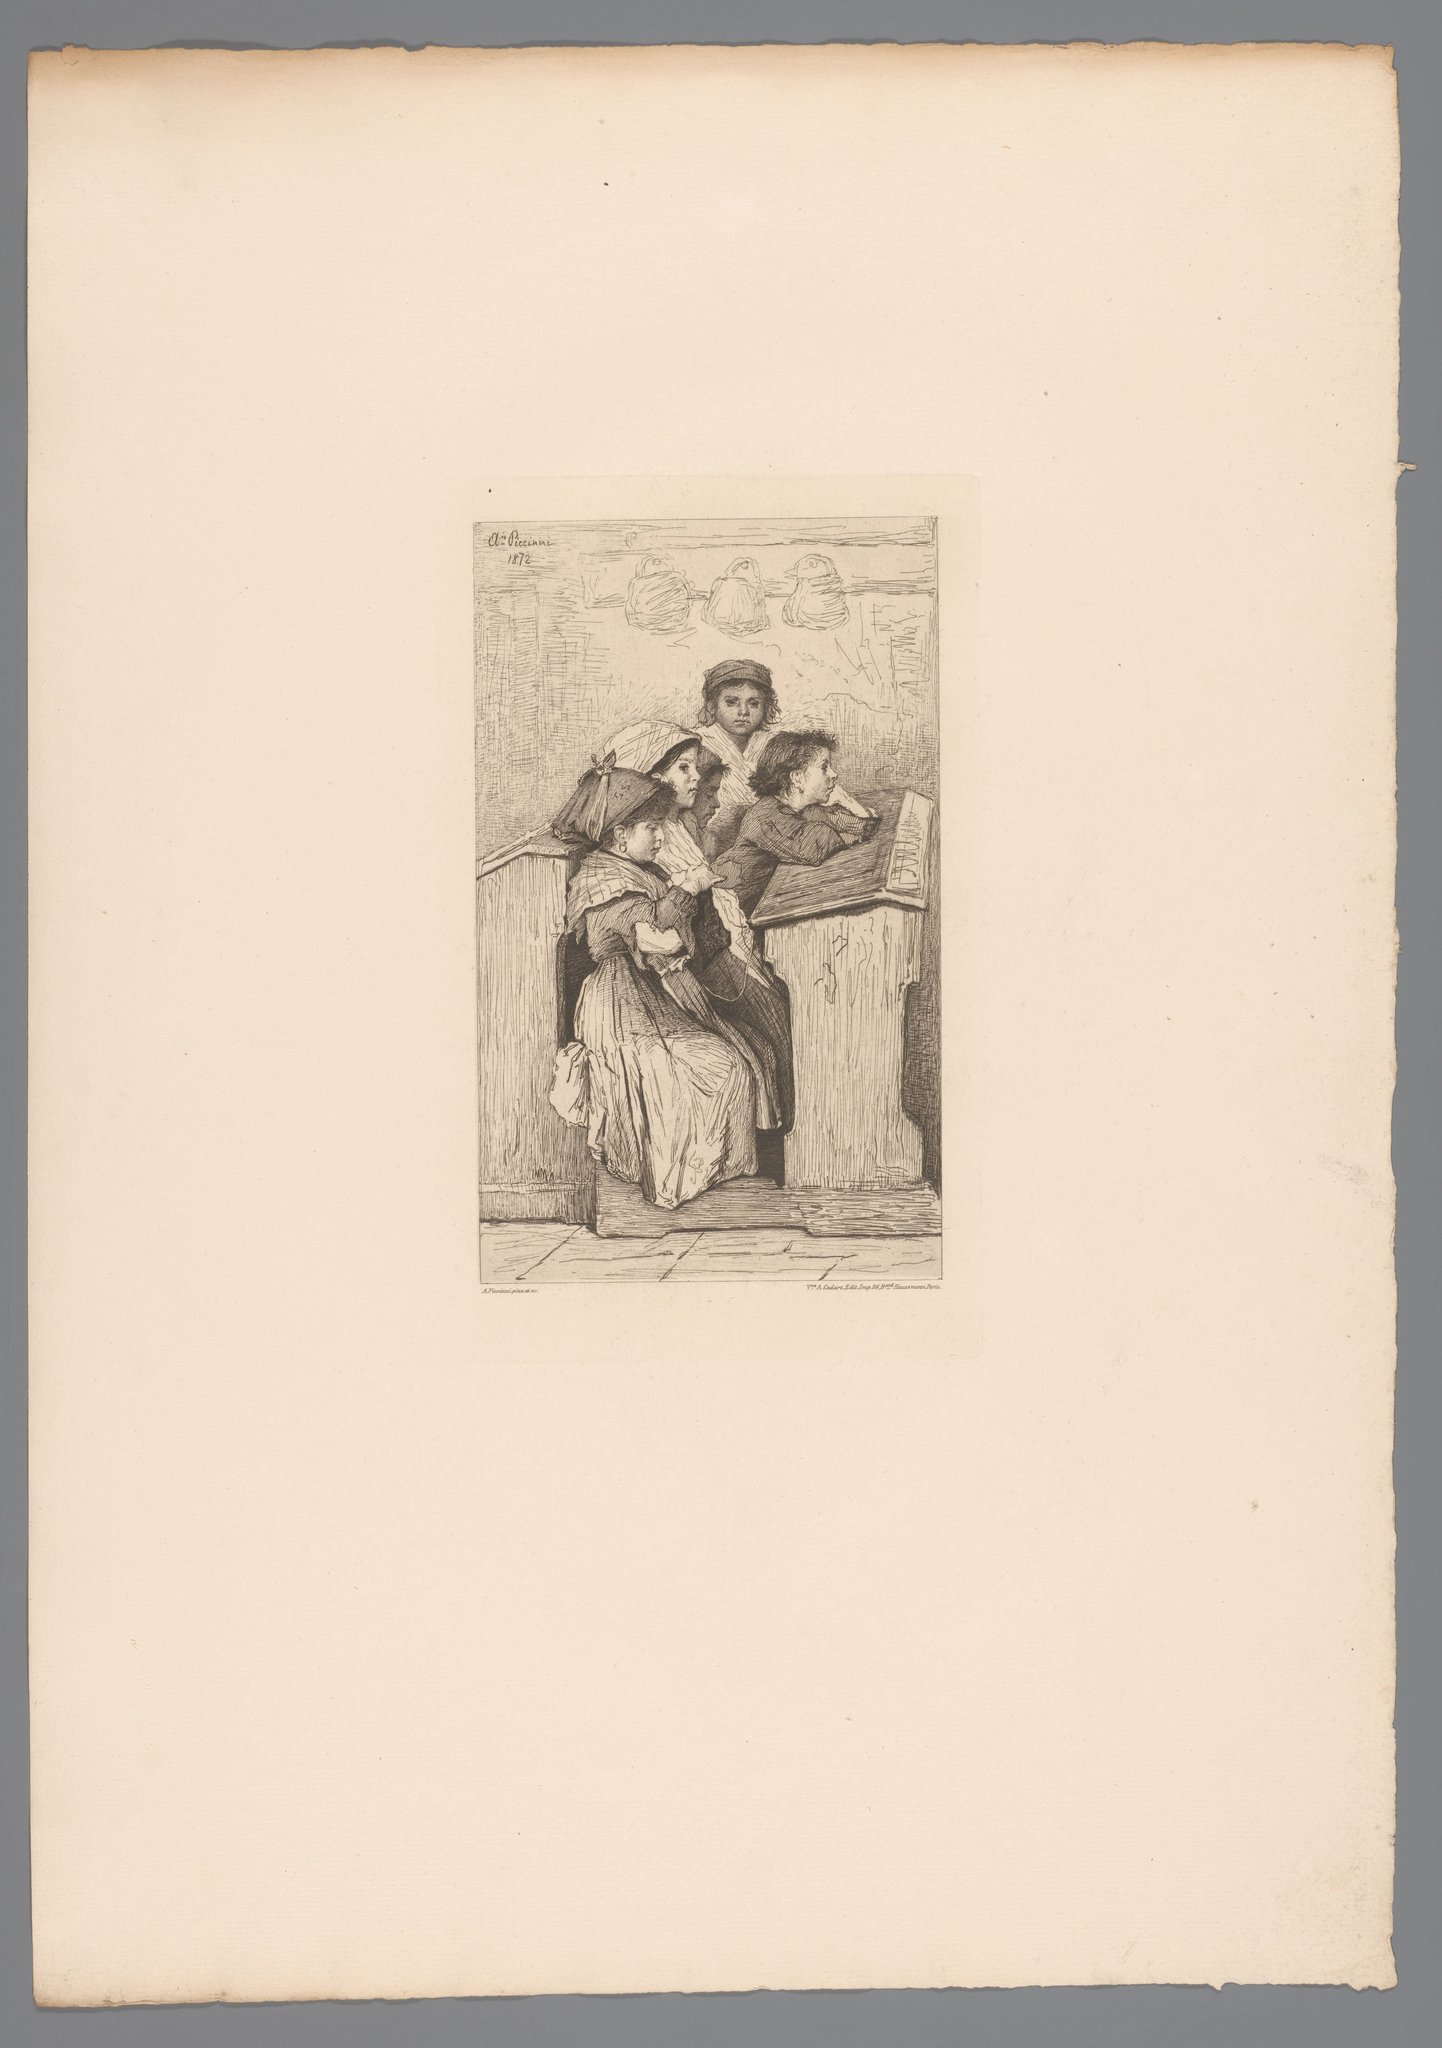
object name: print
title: Vijf kinderen in een kerkbank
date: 1879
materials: paper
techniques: drypoint, etching, intaglio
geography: paris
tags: the place of worship and its equipment ~ christian churches, child, italy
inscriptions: collector's mark: Lugt 2760, watermark, collector's mark: Lugt 2228, collector's mark: ‘AFE v S’